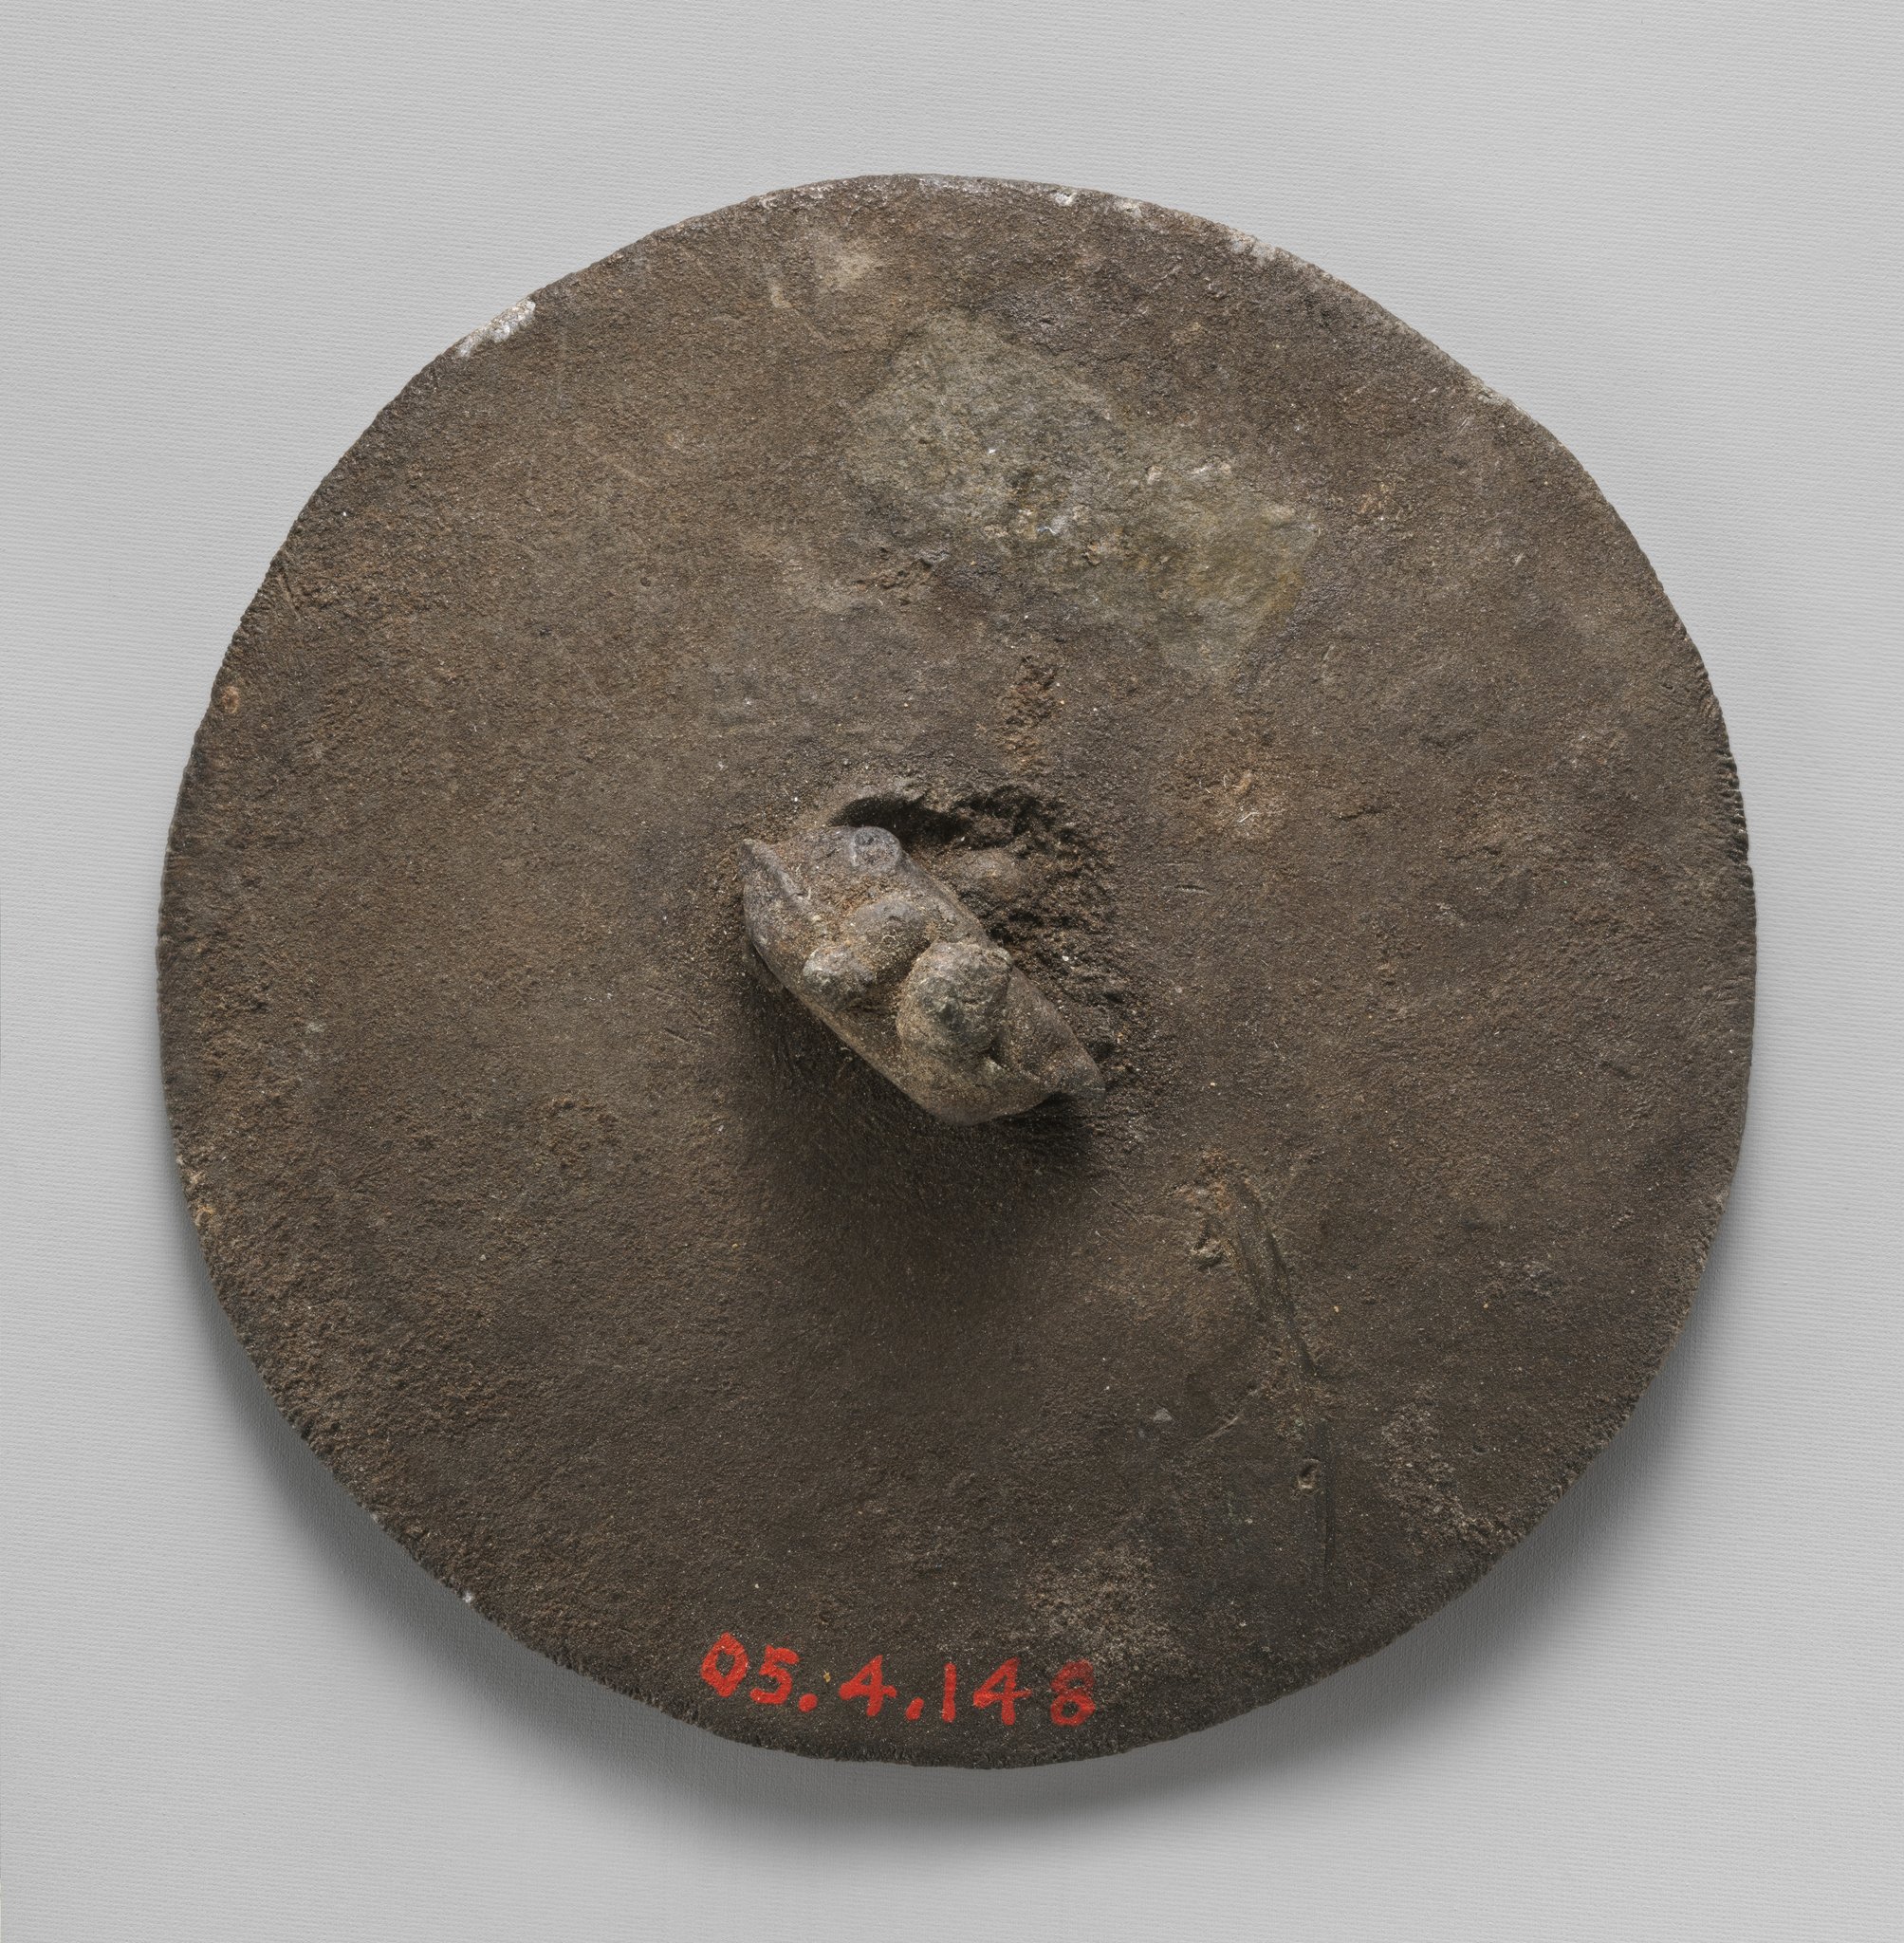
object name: disk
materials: copper alloy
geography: egypt